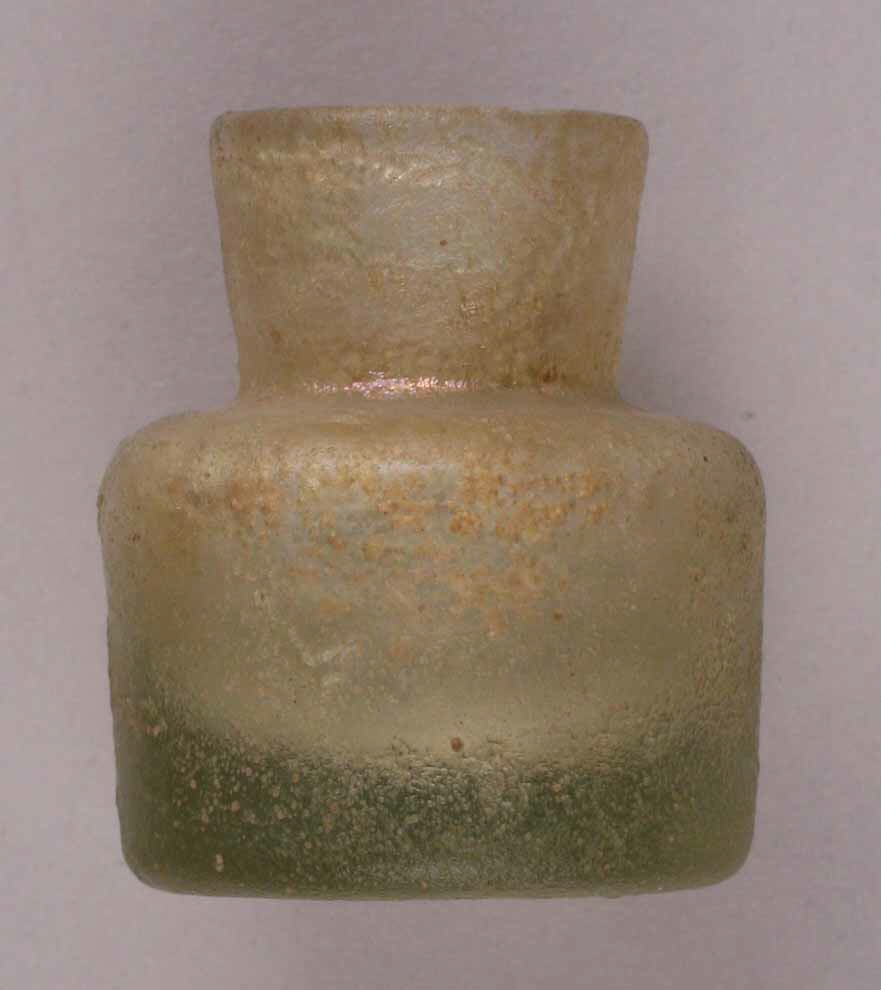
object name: bottle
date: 801-1000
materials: glass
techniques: glassblowing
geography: iran